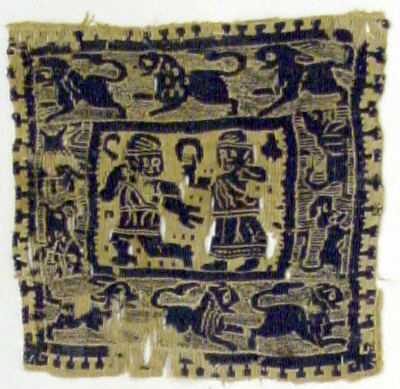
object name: textile fragment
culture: coptic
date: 300-600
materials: linen, wool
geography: egypt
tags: human figures,animals